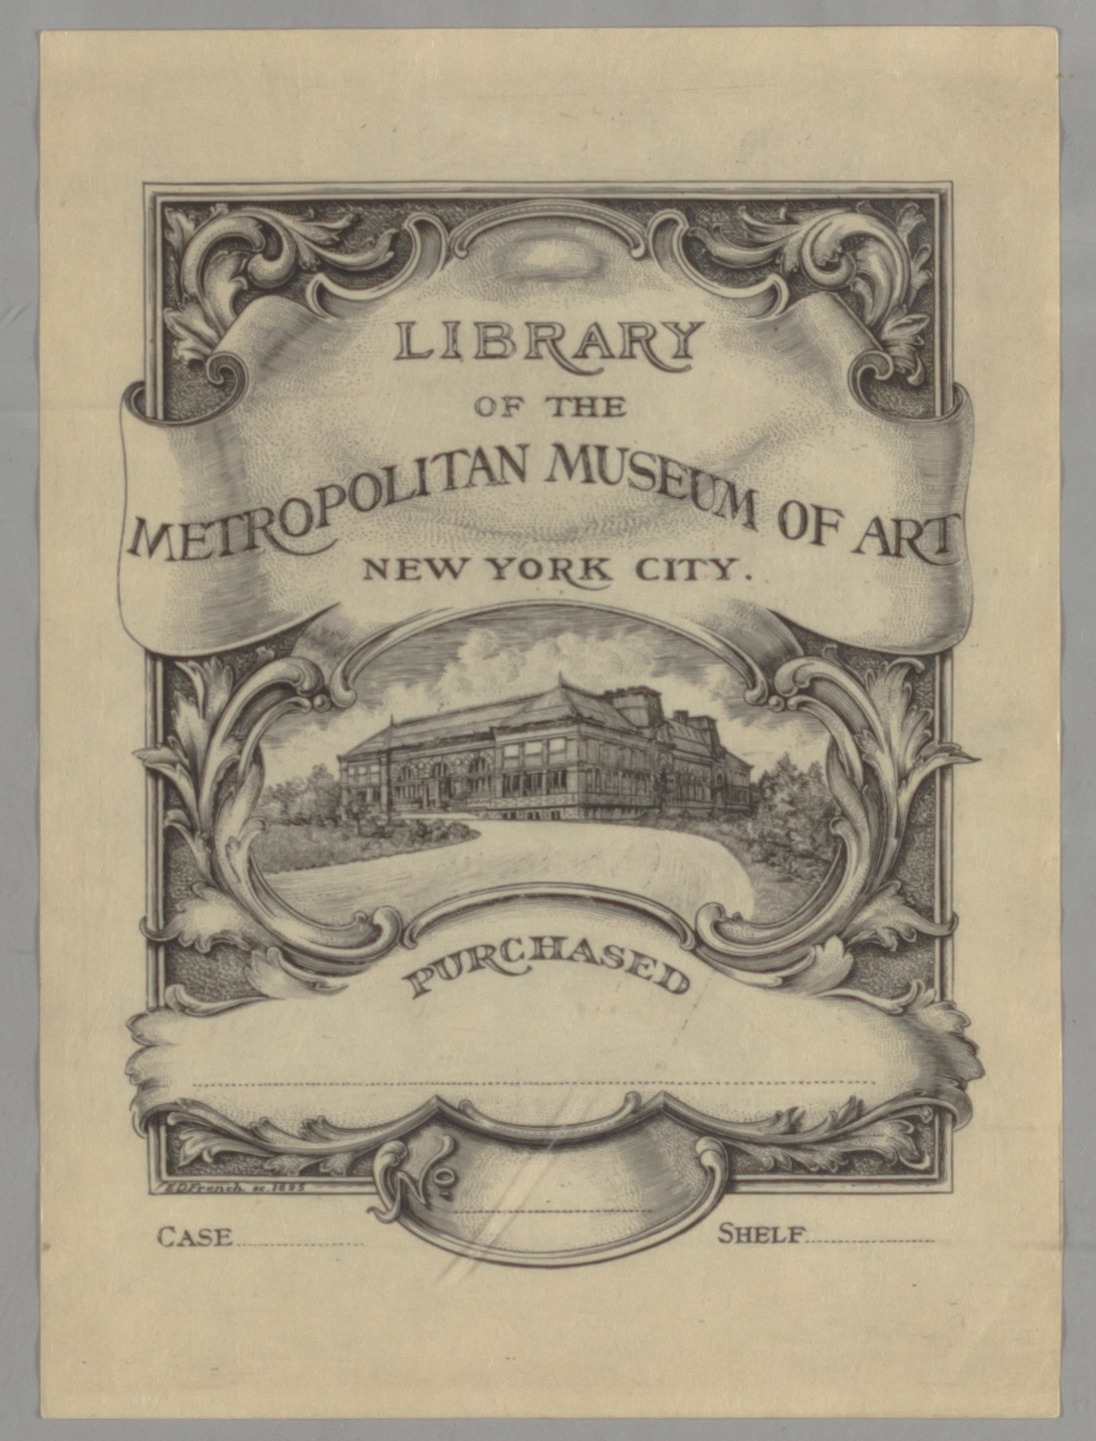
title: Library of the Metropolitan Museum of Art bookplate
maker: edwin davis french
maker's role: engraver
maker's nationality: american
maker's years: 1851-1906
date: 1895